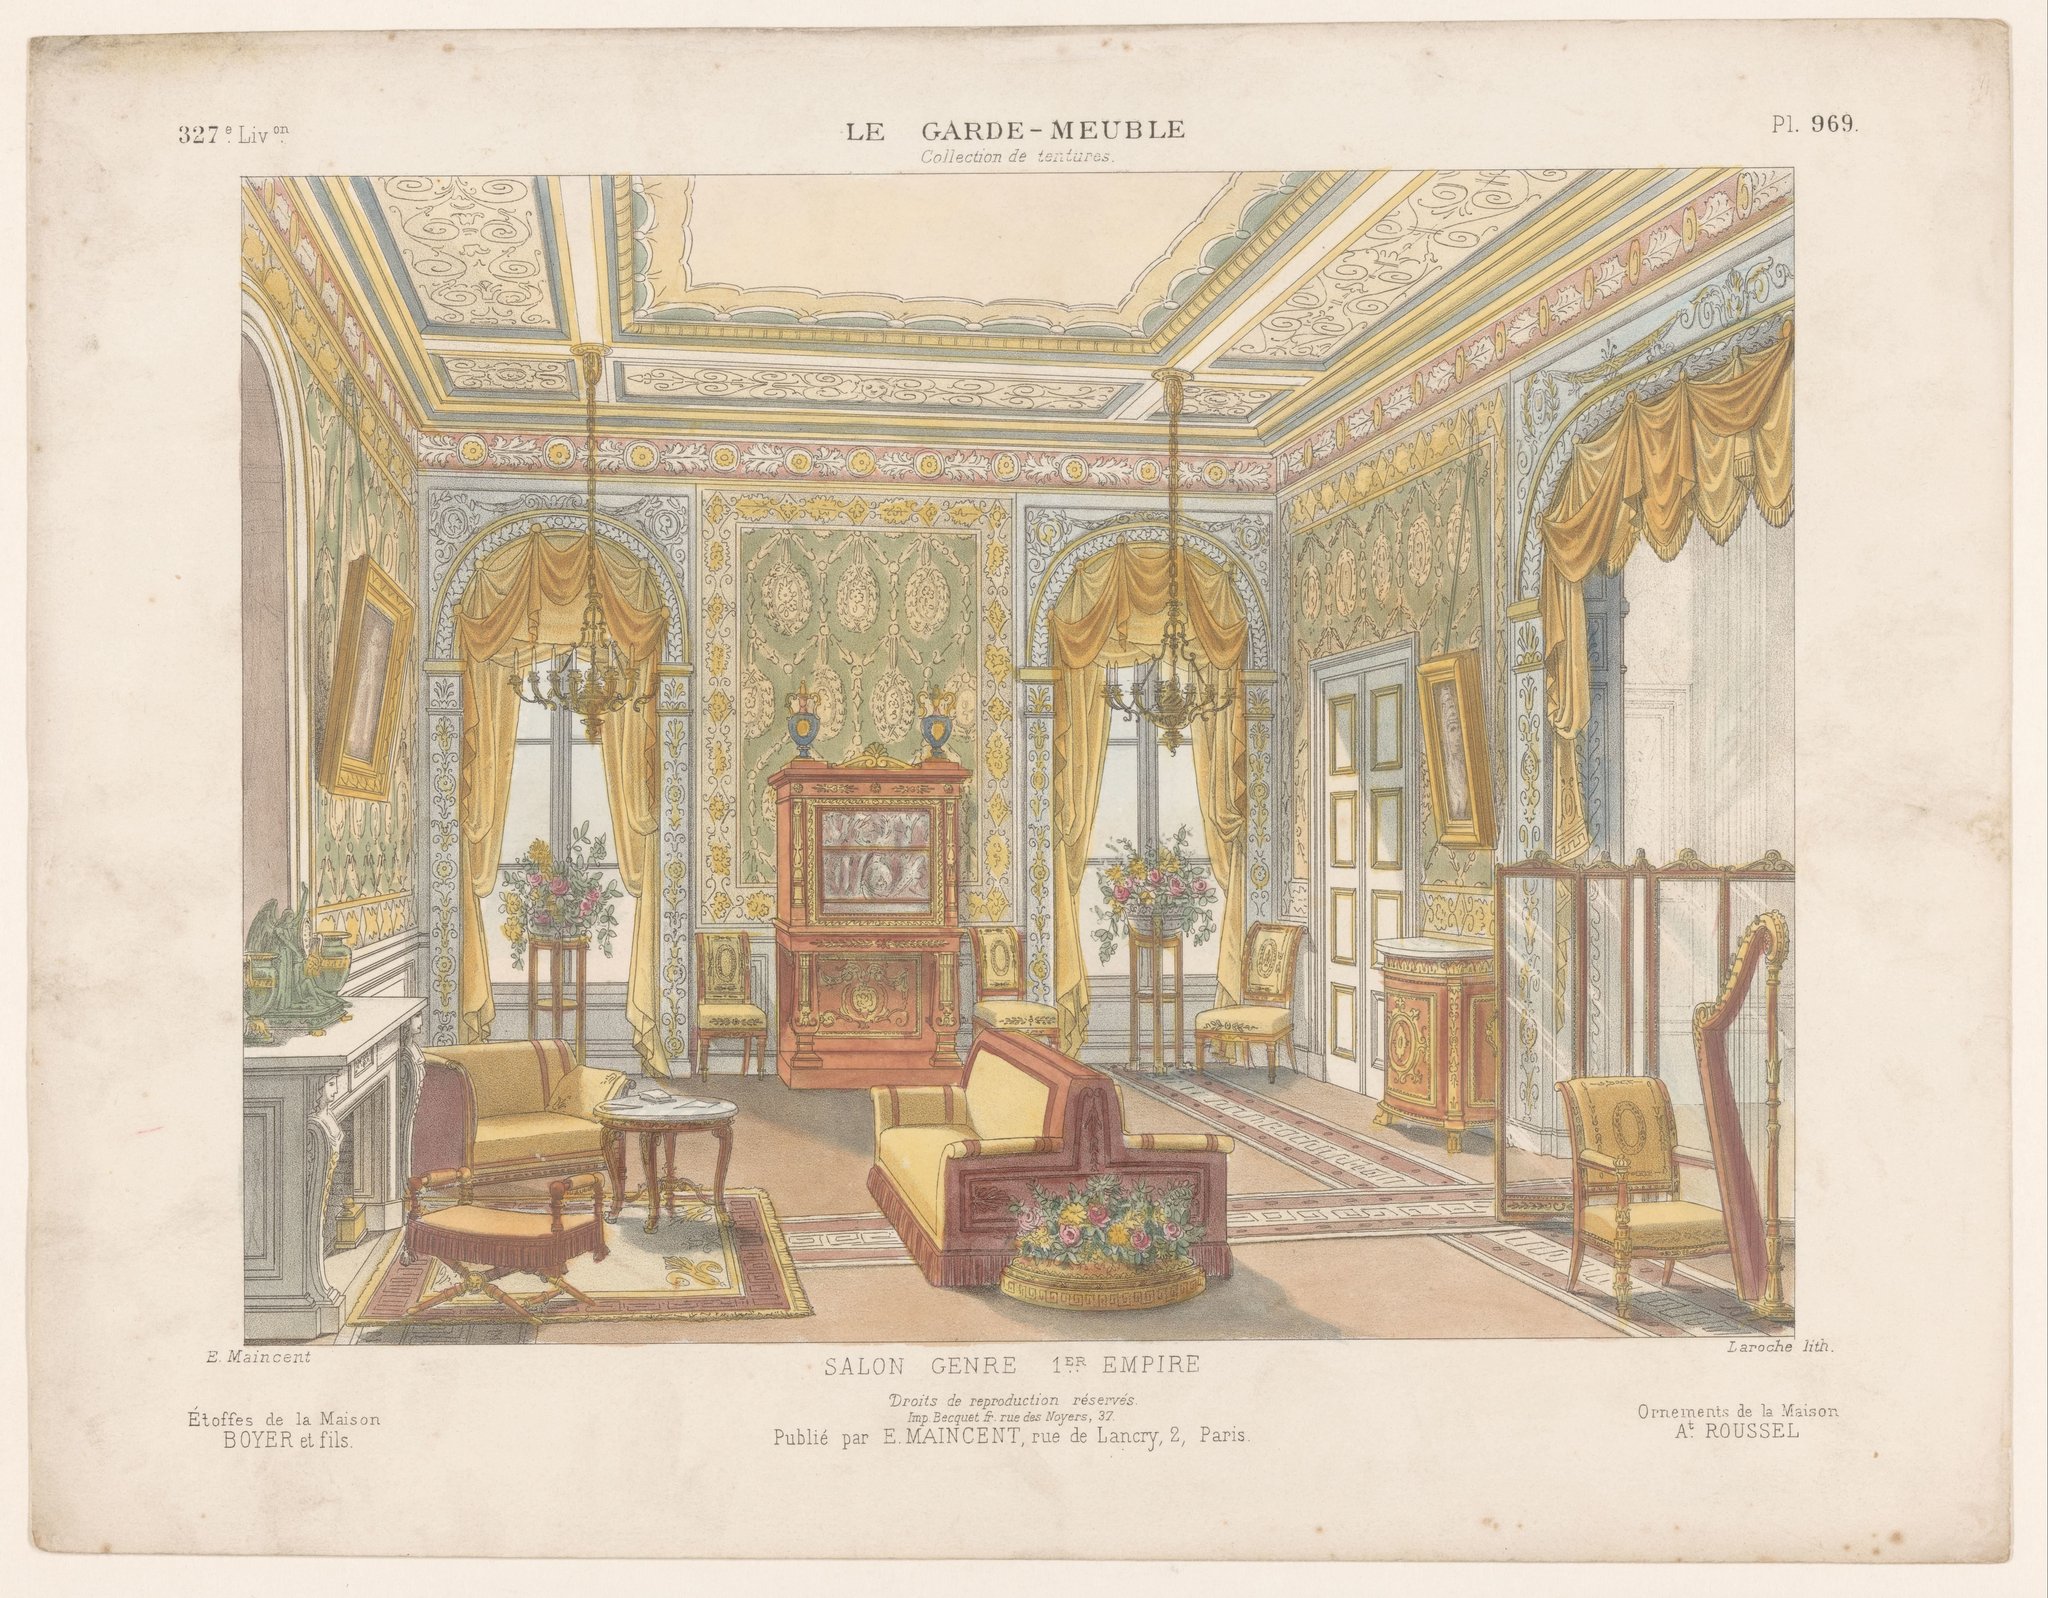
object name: print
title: Le Garde-Meuble / Collection de Tentures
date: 1885-1895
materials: paper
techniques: hand coloring, lithograph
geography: paris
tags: decorations (interior of the house), drawing-room, 'salon', hangings and drapery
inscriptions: : ‘Droits de reproduction réservés.’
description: Interieur van een salon in empirestijl (Eerste Franse Keizerrijk). Prent uit 327e Livraison.